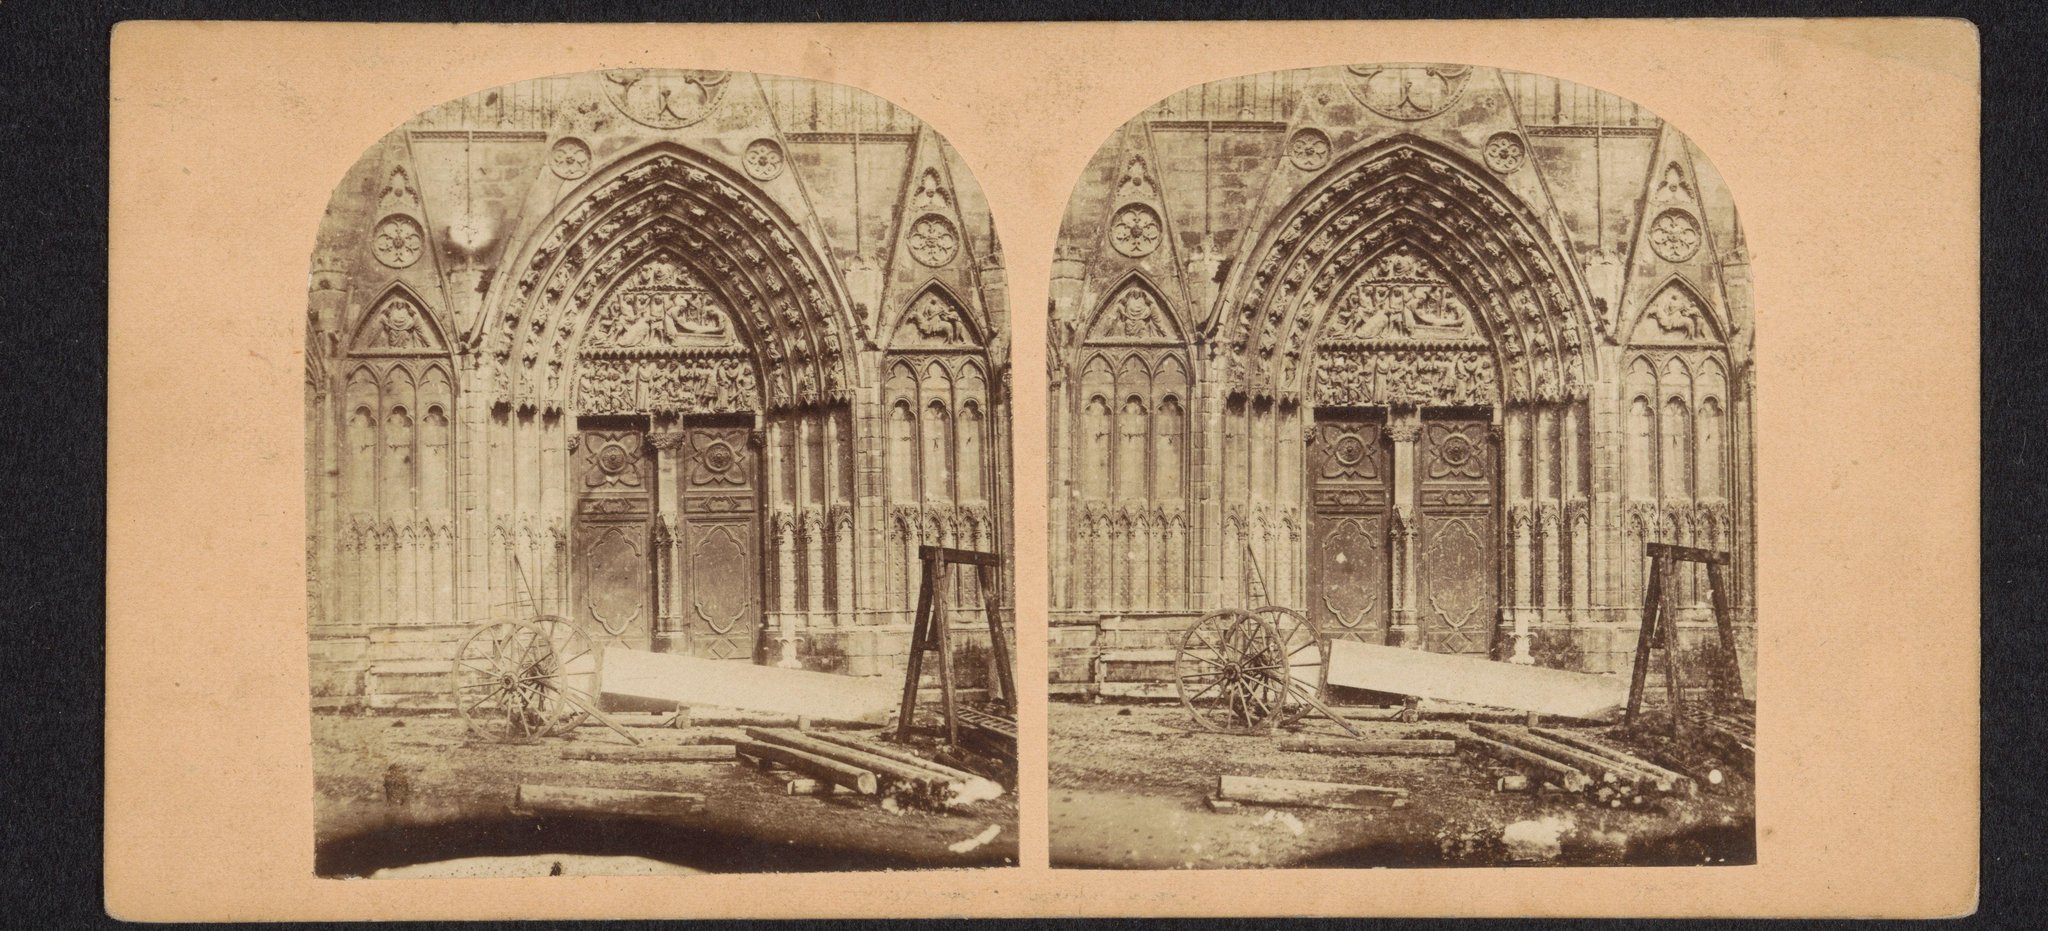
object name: stereograph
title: Gezicht op een portaal van de Notre-Dame in Parijs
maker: Anonymous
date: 1855-1860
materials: cardboard, photographic support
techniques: albumen print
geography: paris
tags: parts of church exterior and annexes: portal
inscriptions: inscription: ‘Portail Notre Dame Paris.’, number: ‘69’